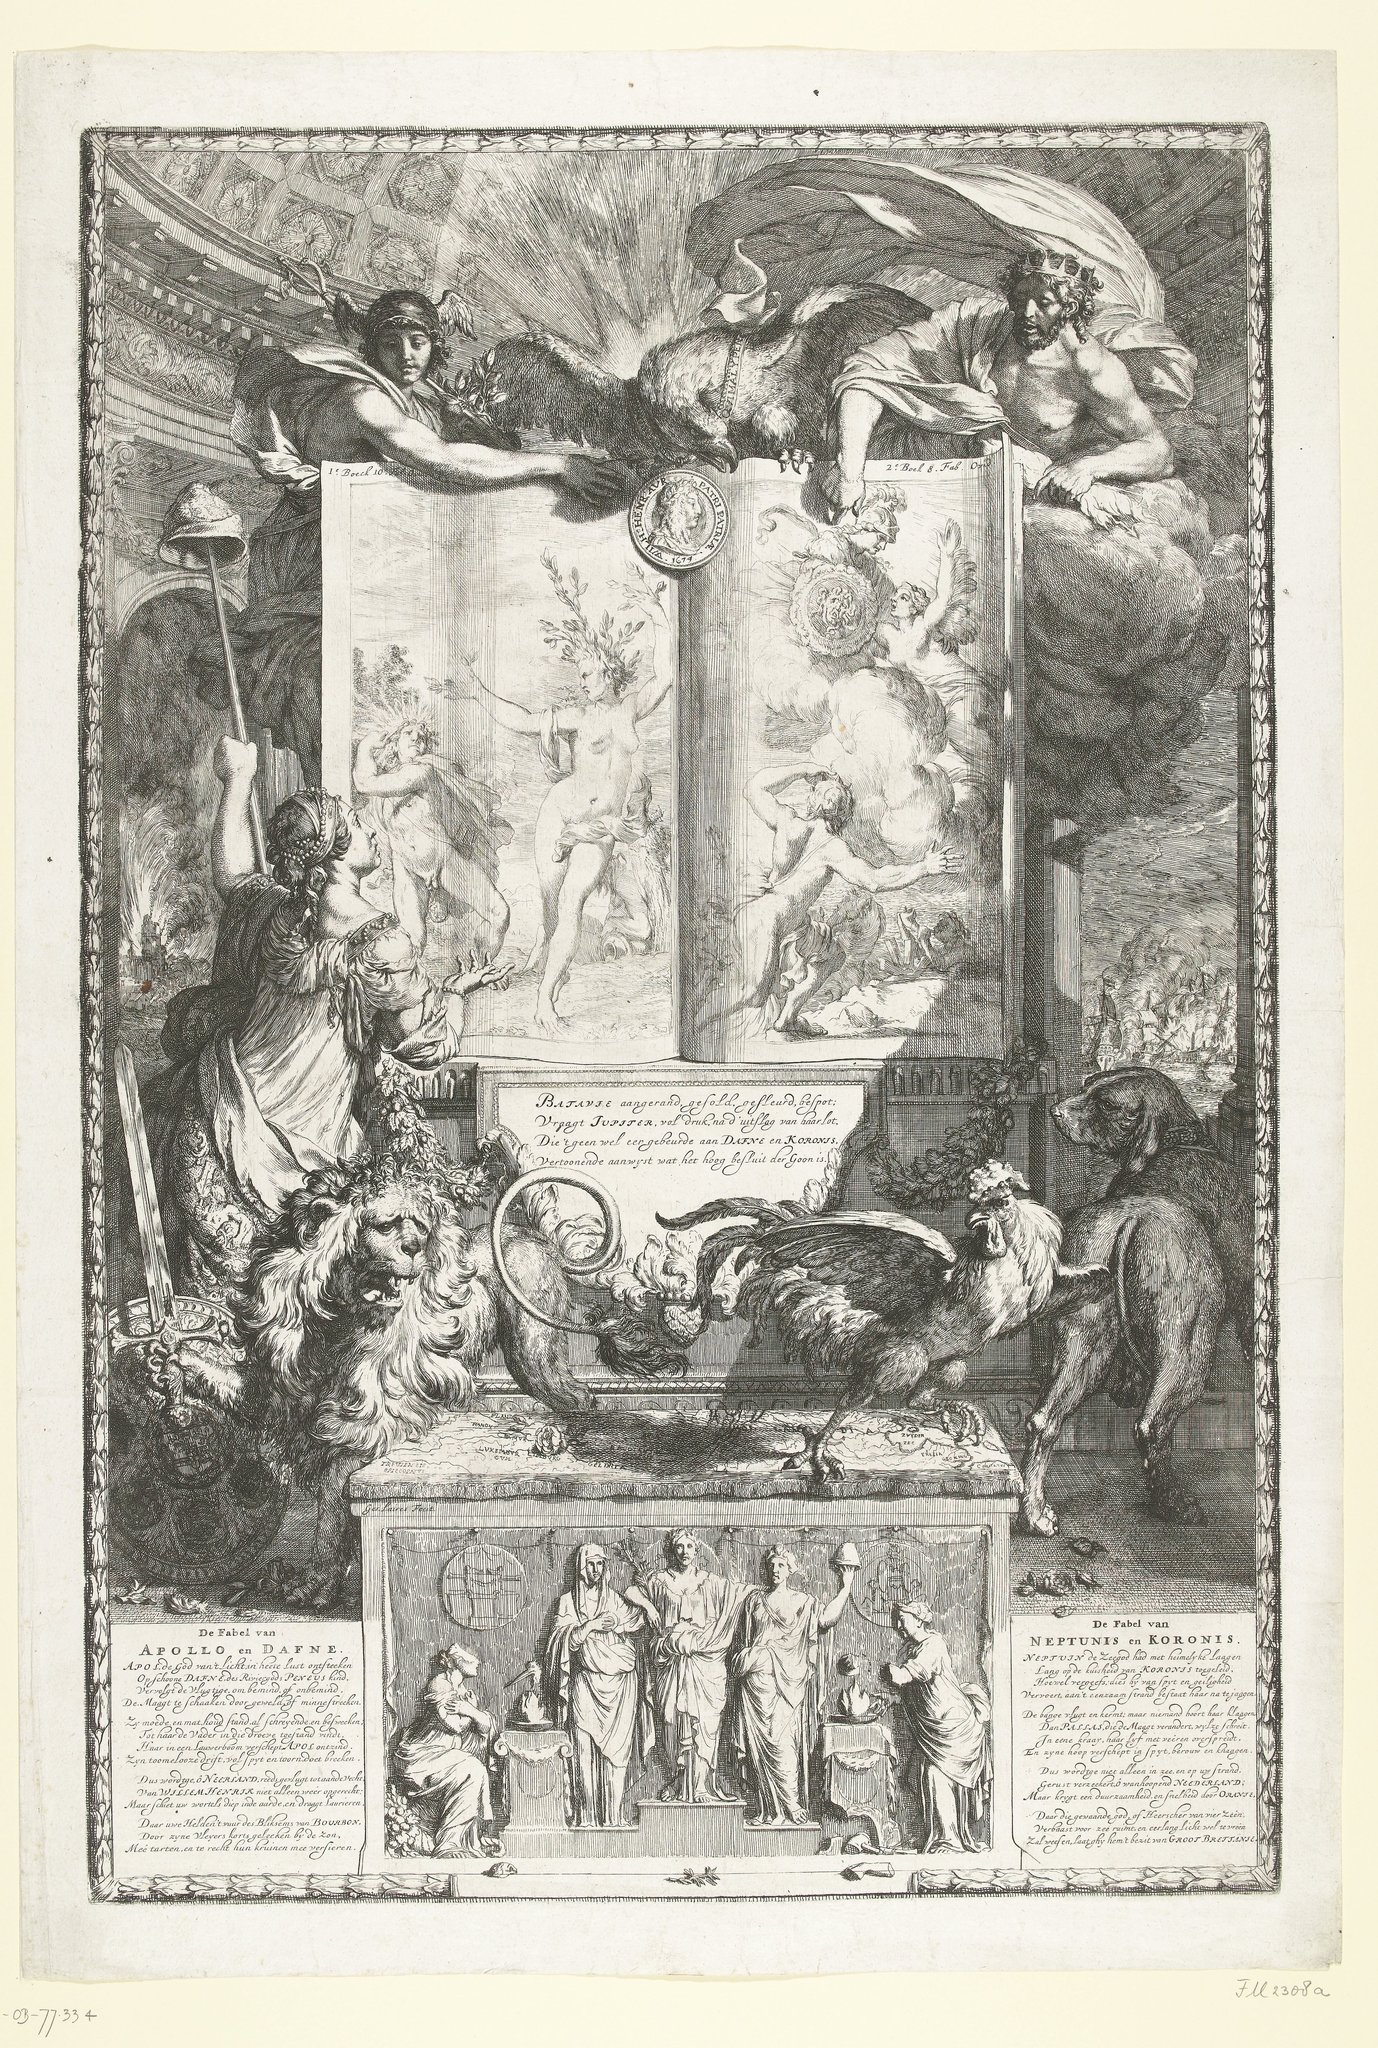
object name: print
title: Zinneprent op de overwinning van Nederland onder het leiderschap van Willem III, 1674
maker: gerard de lairesse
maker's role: draughtsman, painter, print maker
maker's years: 1641-1711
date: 1674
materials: paper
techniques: etching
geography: northern netherlands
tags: the hague, william iii (prince of orange and king of england, scotland, and ireland), coronis changed into a crow: to escape the love of neptune, coronis, daughter of coroneus, is changed into a crow by minerva (ovid, metamorphoses ii 569), daphne changed into a laurel-tree: while fleeing from apollo, daphne is changed into a laurel-tree by her father peneus (ovid, metamorphoses i 548)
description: Grote allegorische voorstelling op de overwinning van de Republiek onder het leiderschap van Willem III in 1674. Door middel van twee verhalen uit de Griekse mythologie wordt de overwinning van de Verenigde Nederlanden onder het leiderschap van prins Willem op haar vijanden, vastgelegd in de Vrede van Westminster op 19 februari 1674, verheerlijkt. Mercurius en Jupiter wijzen de Nederlandse Maagd met de vrijheidshoed op een openstaand boek van de Metamorphosen van Ovidius waarin scènes uit de verhalen van Apollo en Daphne en Neptunus en Coronis te zien zijn. Hieronder de Nederlandse Leeuw die de Franse haan en een Engelse hond verjaagt. Onderaan worden links en rechts de fabelen en de politieke interpretatie uitgelegd.